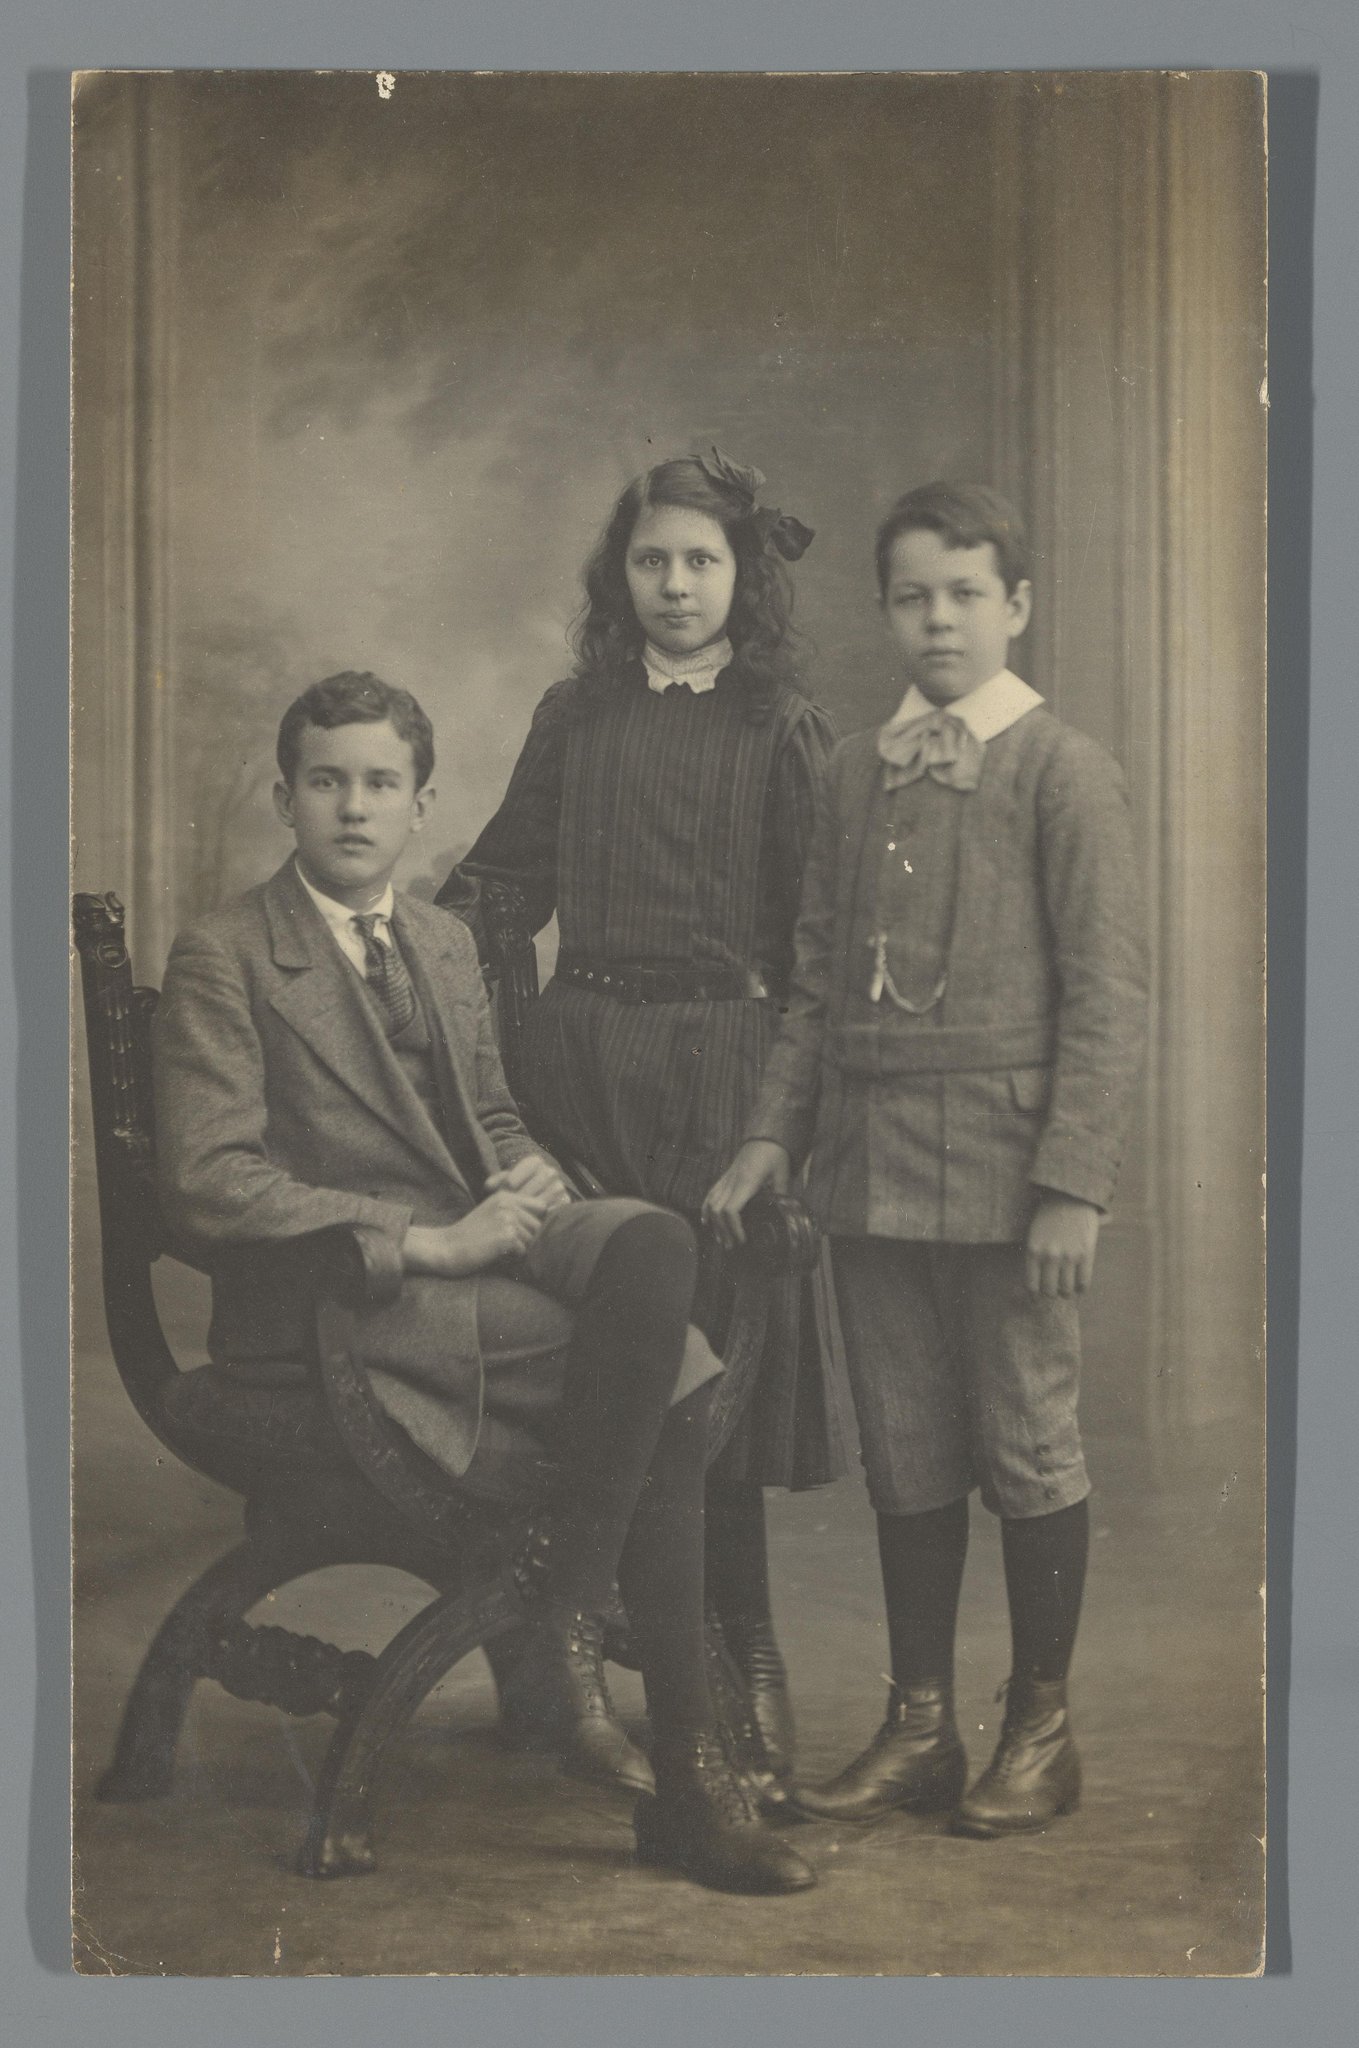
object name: photograph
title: Portret van drie jonge mensen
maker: Anonymous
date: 1855-1910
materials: photographic support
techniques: photography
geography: netherlands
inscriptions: seal, stamp, inscription